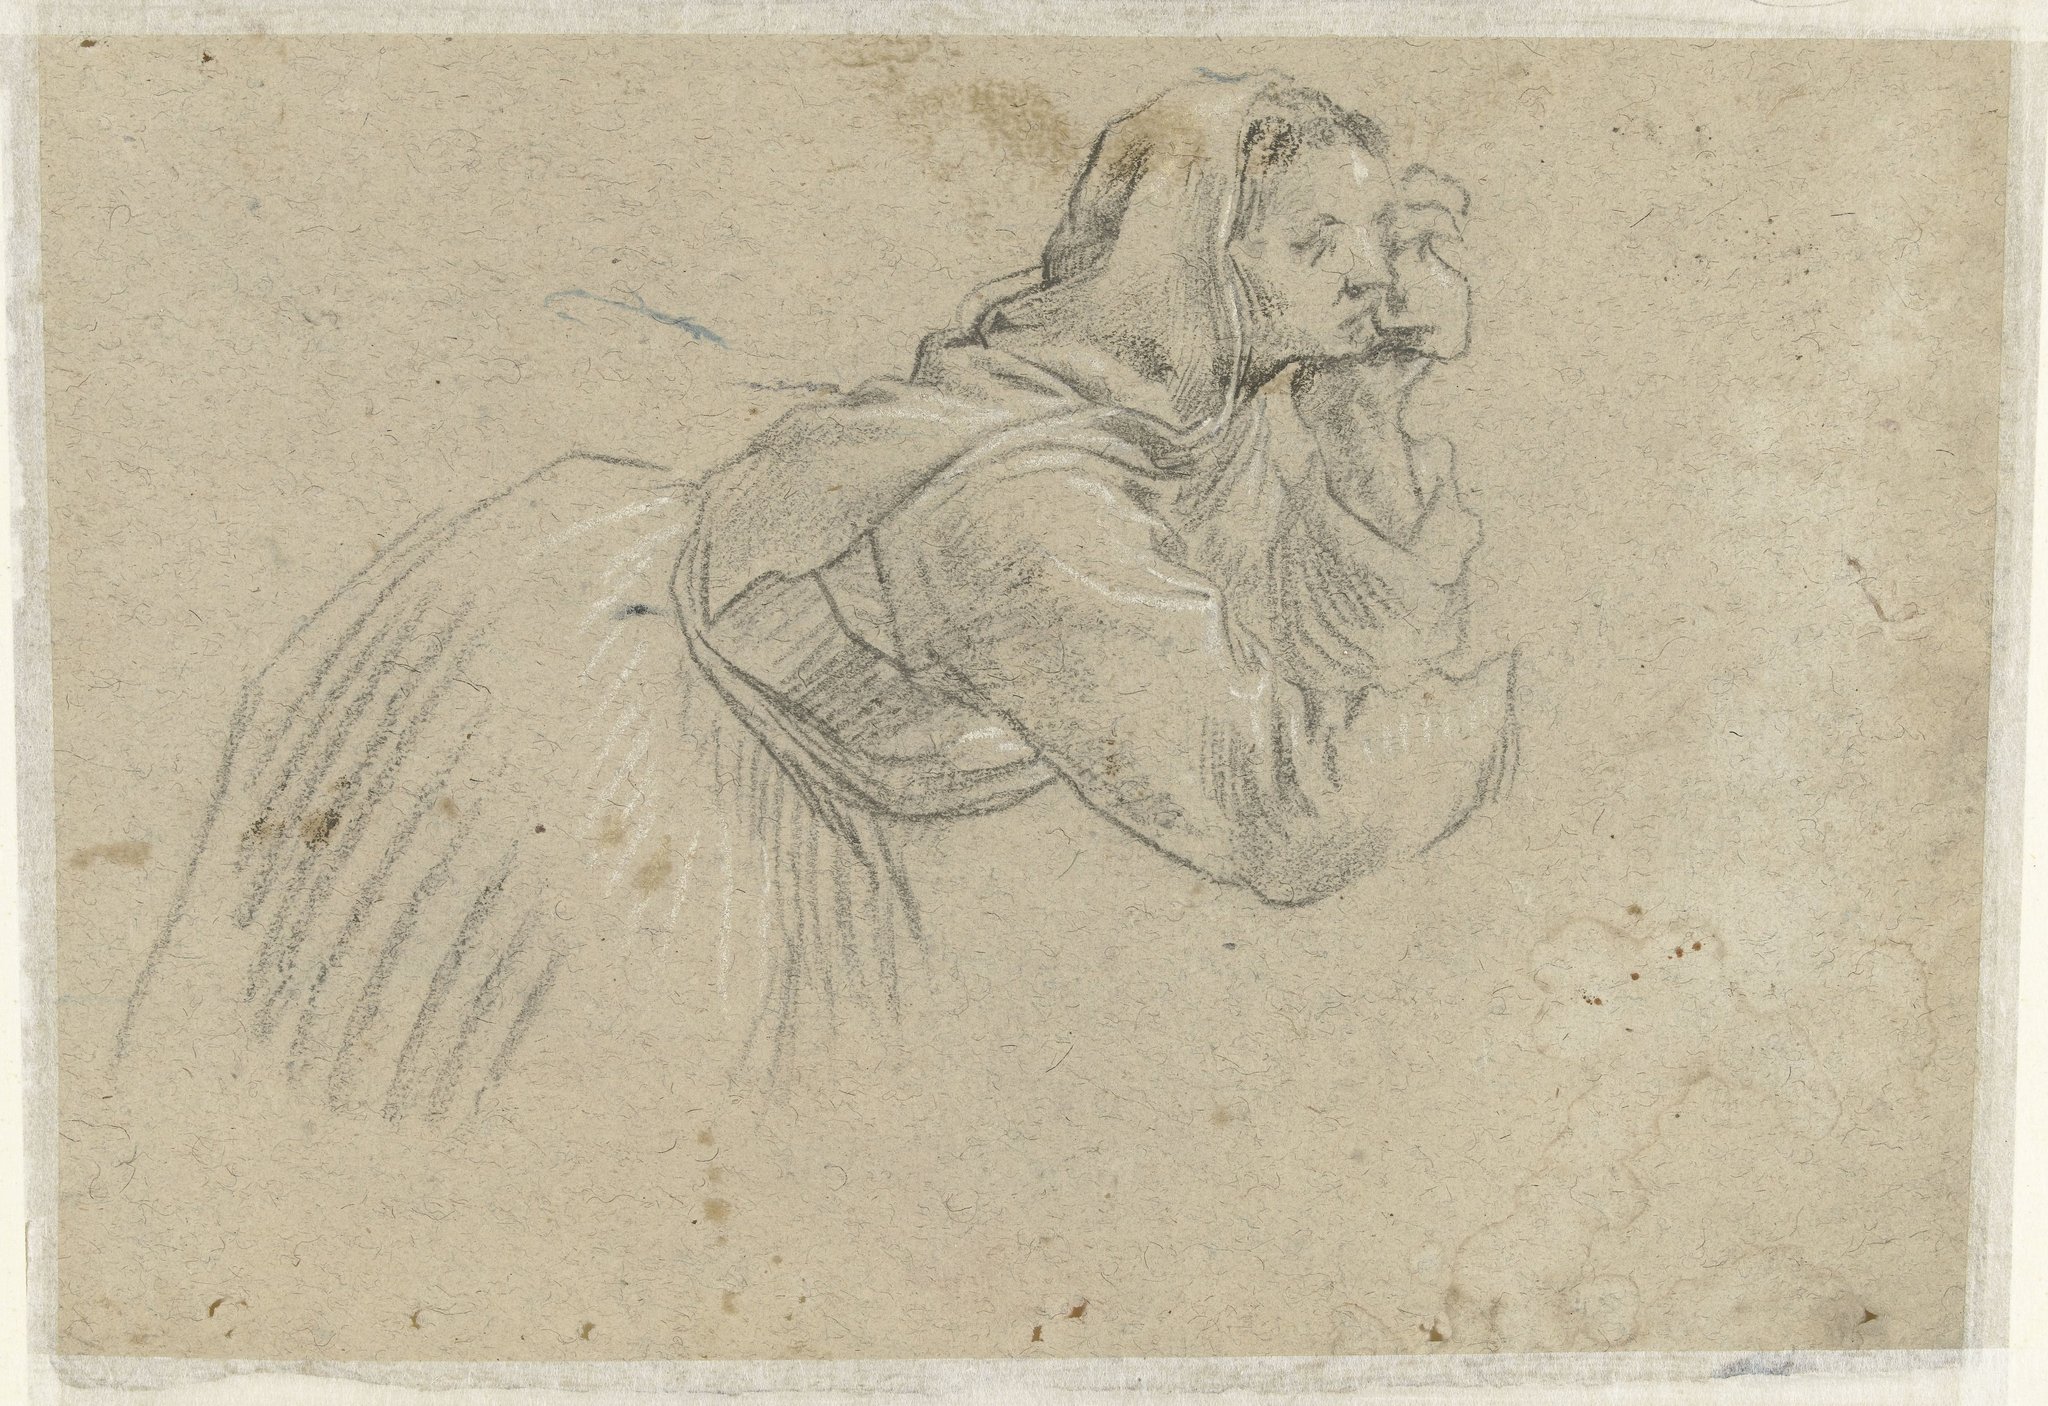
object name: drawing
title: Knielende wenende vrouw (Maria Magdalena?)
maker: Anonymous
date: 1610-1630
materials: chalk, paper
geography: verona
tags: kneeling figure - aa - female human figure, the penitent st. mary magdalene (often before a cave, possibly at la sainte-baume hill): her long hair covers her (naked) body, she reads, meditates or raises her tear-filled eyes towards heaven, crucified christ with mary magdalene, who usually weeps and embraces the cross, weeping